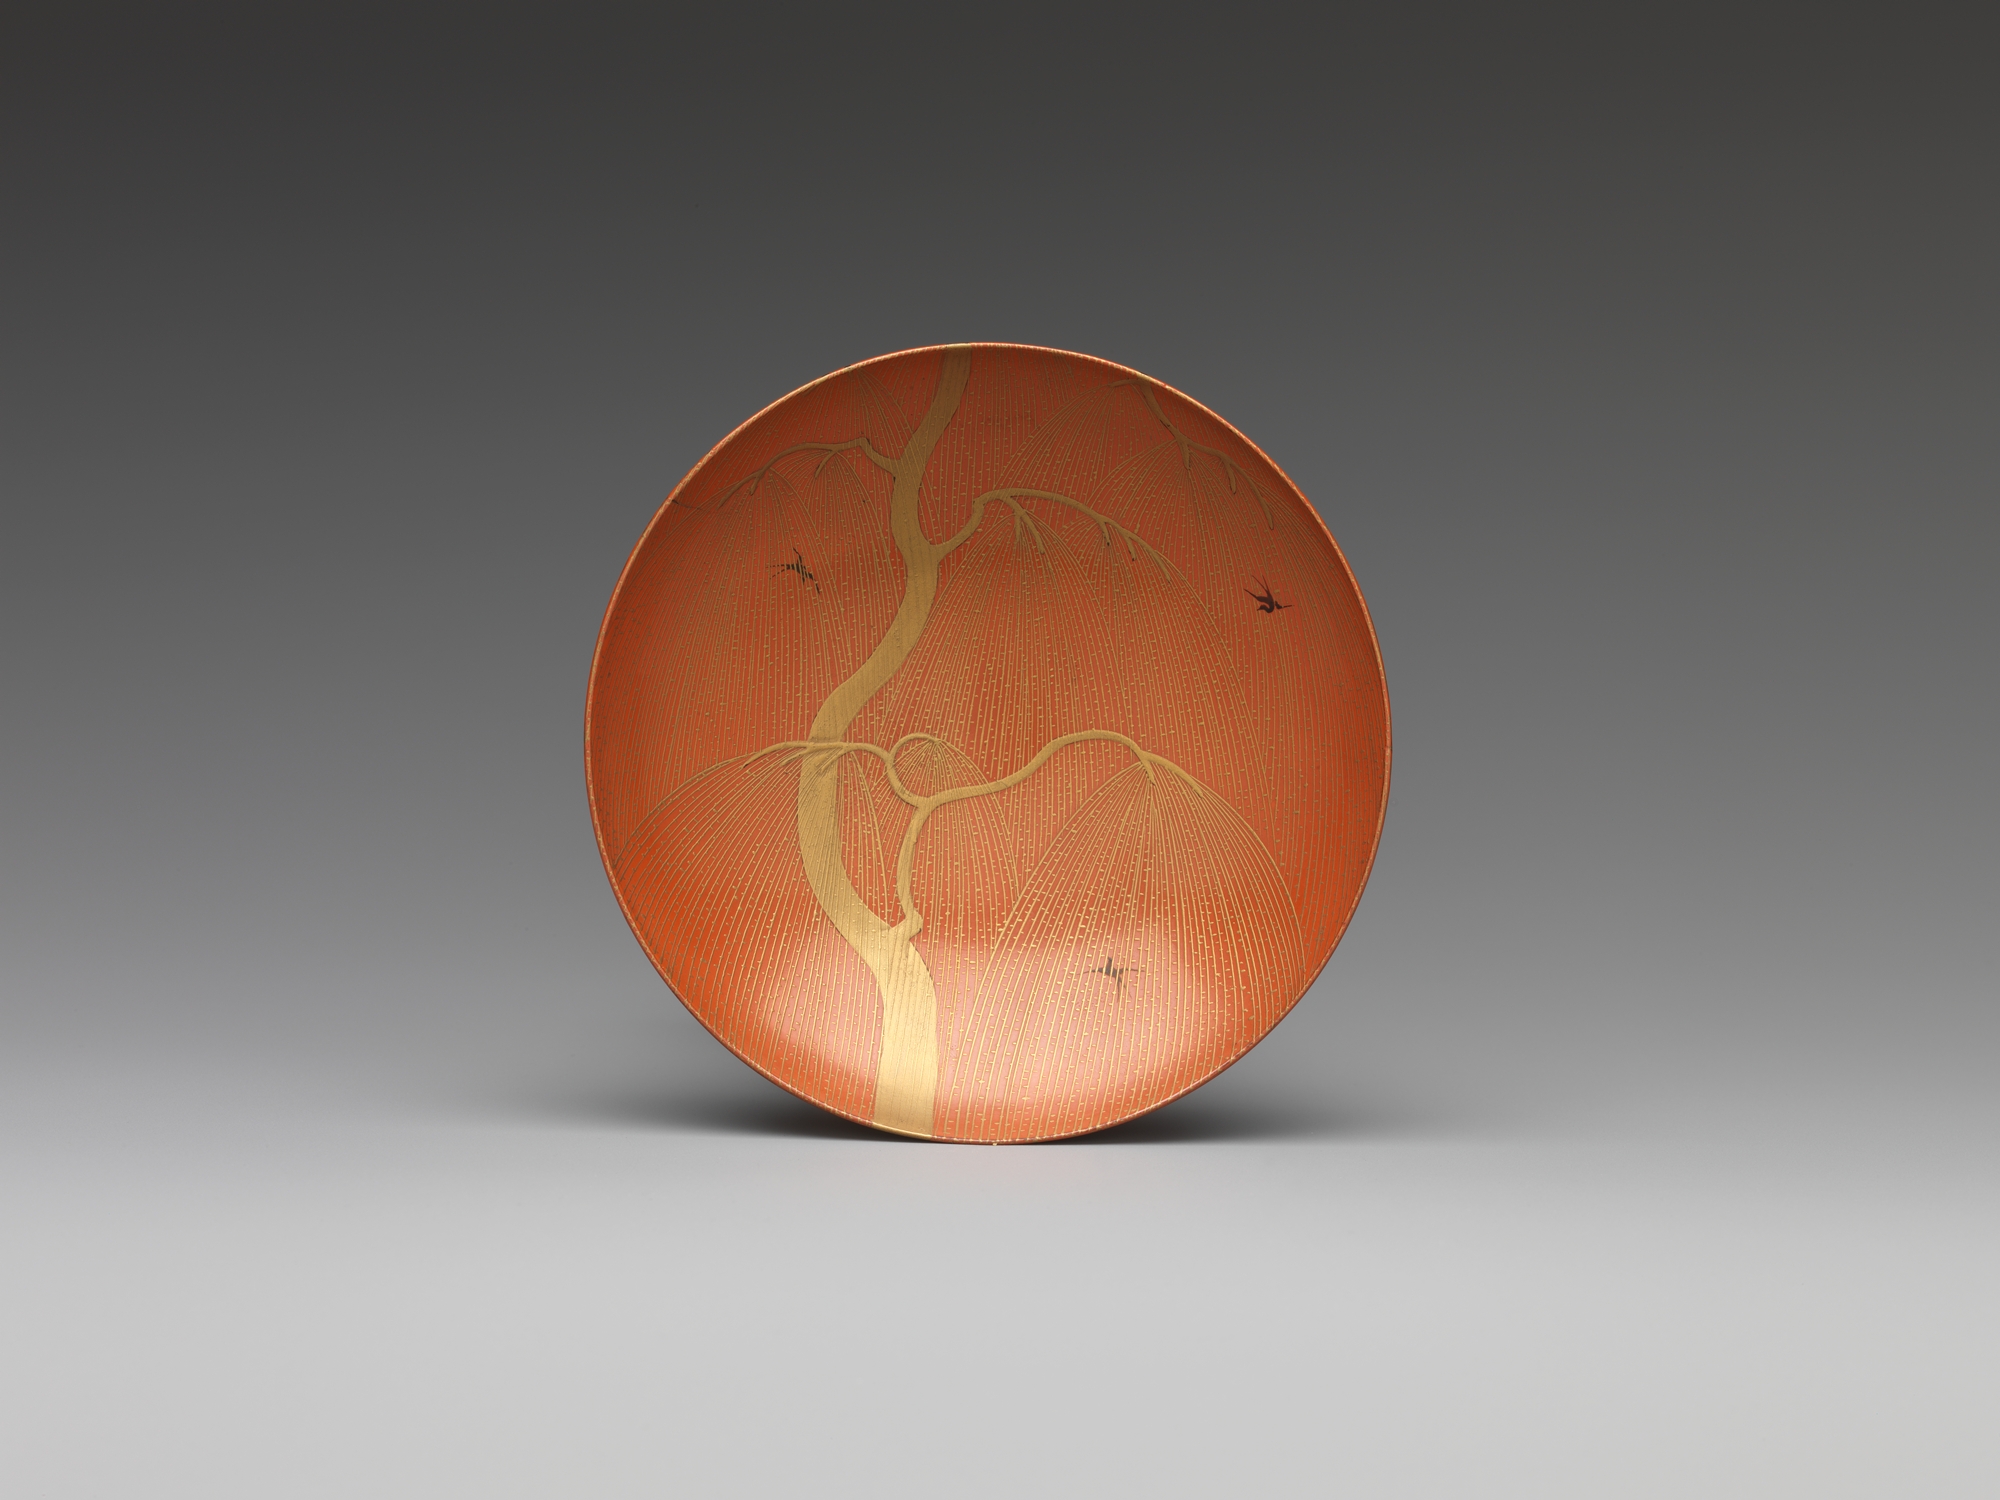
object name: wine cup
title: One of a Pair of Wine Cups (Sakazuki) with Willow and Swallows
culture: japanese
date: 1801-1900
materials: gold, lacquer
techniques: hiramakie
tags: birds,trees